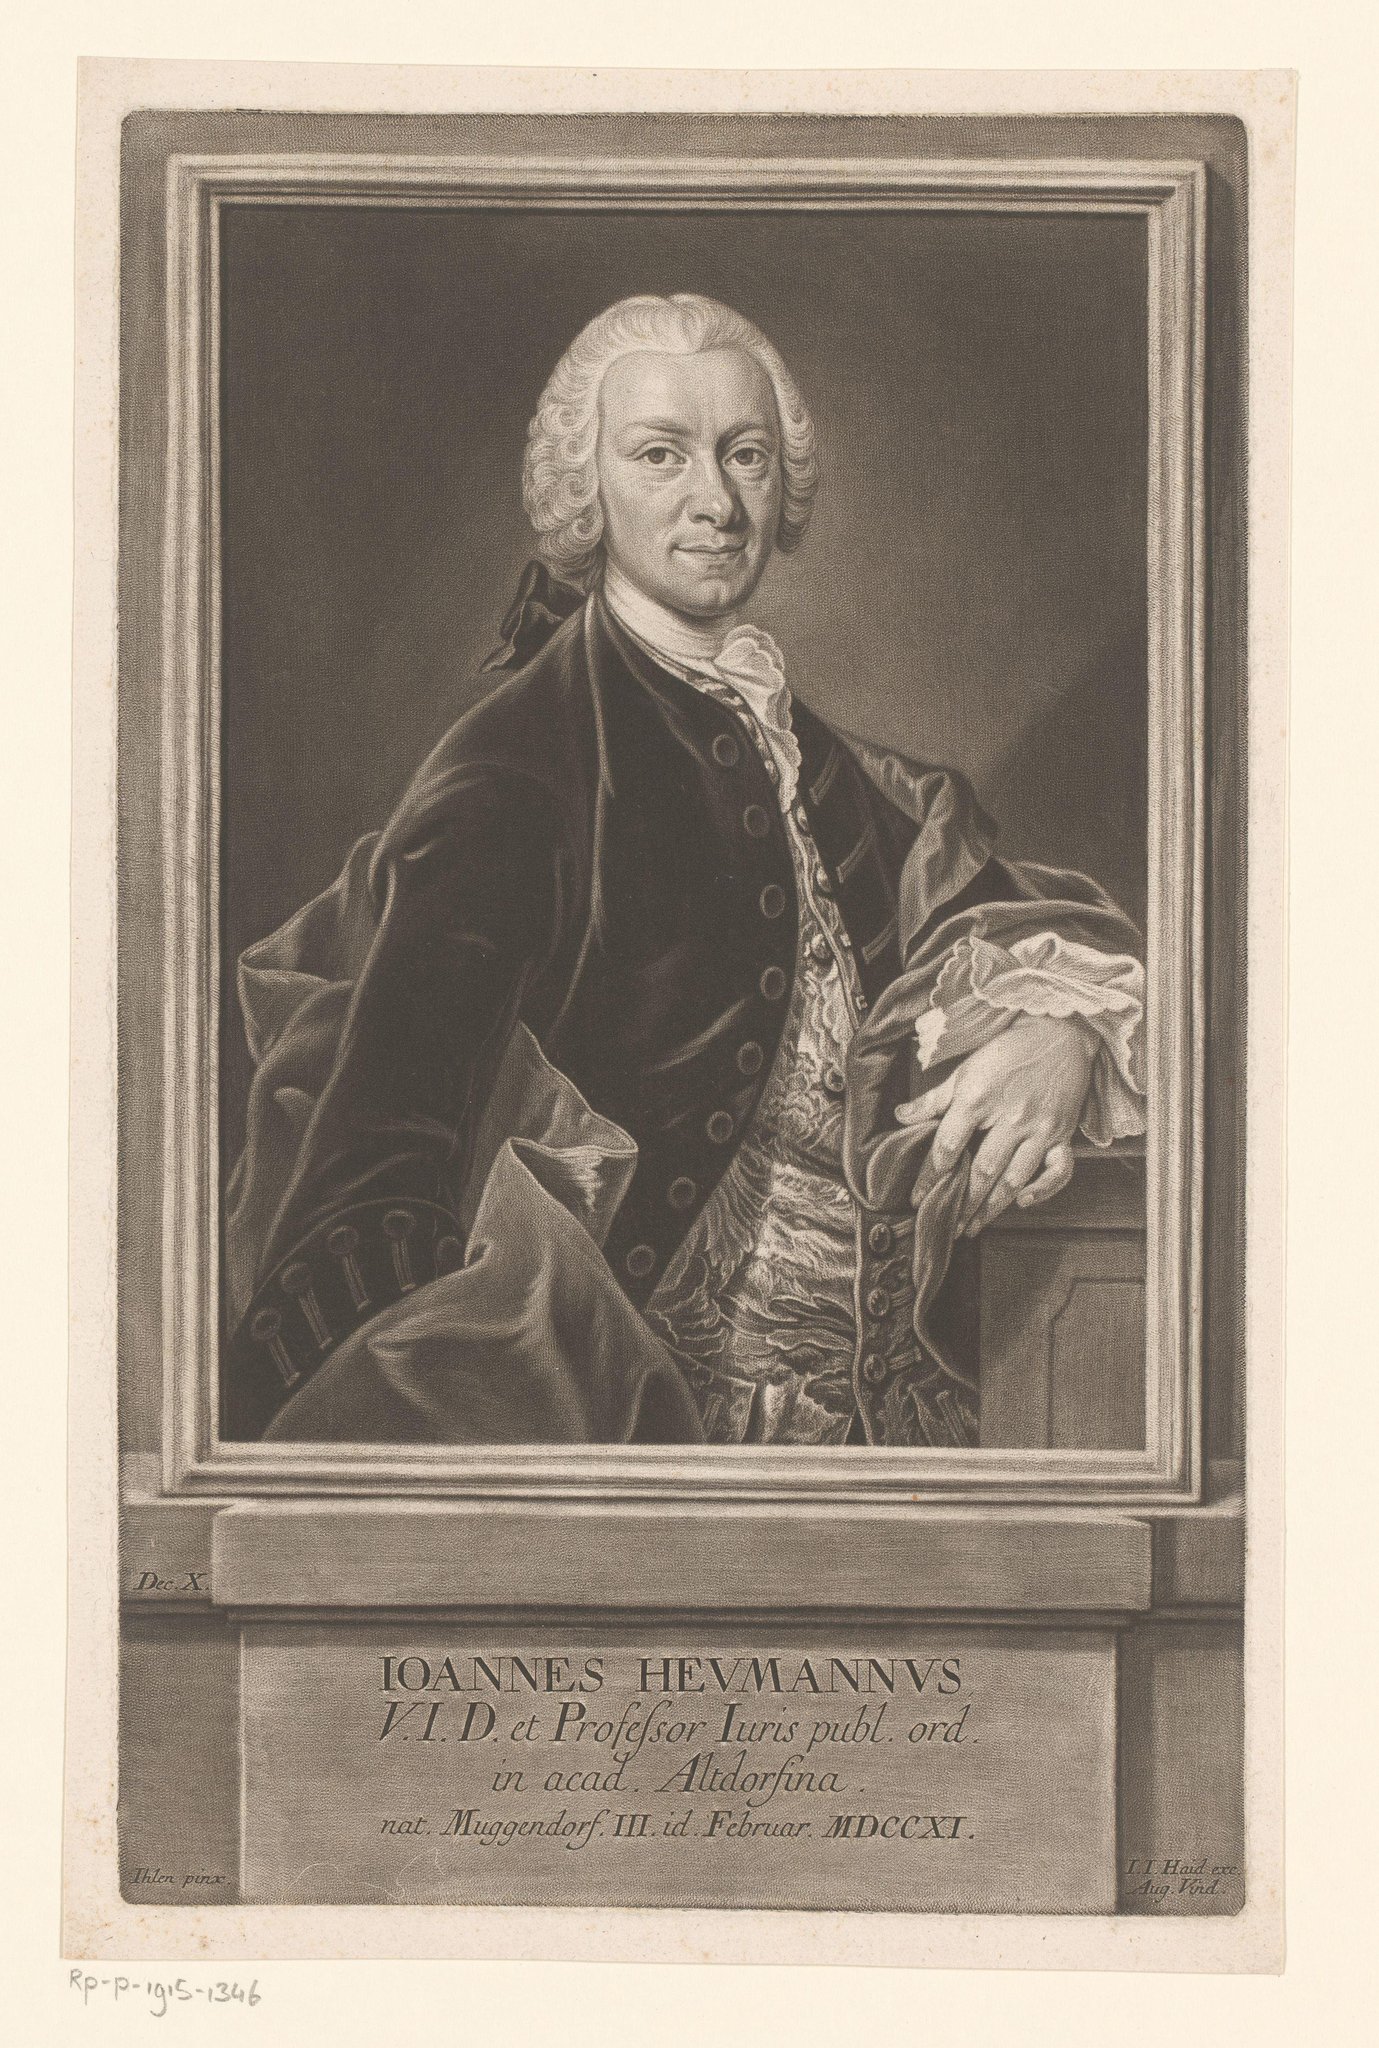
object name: print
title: Portret van Johann Heumann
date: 1755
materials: paper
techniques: mezzotint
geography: augsburg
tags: historical persons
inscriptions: collector's mark: Lugt 2228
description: Prent gebruikt voor: Brucker, Jacob. Bildersal heutiges Tages lebender und durch Gelahrheit berühmter Schrifftsteller. Augsburg: Johann Jacob Haid, 1755.